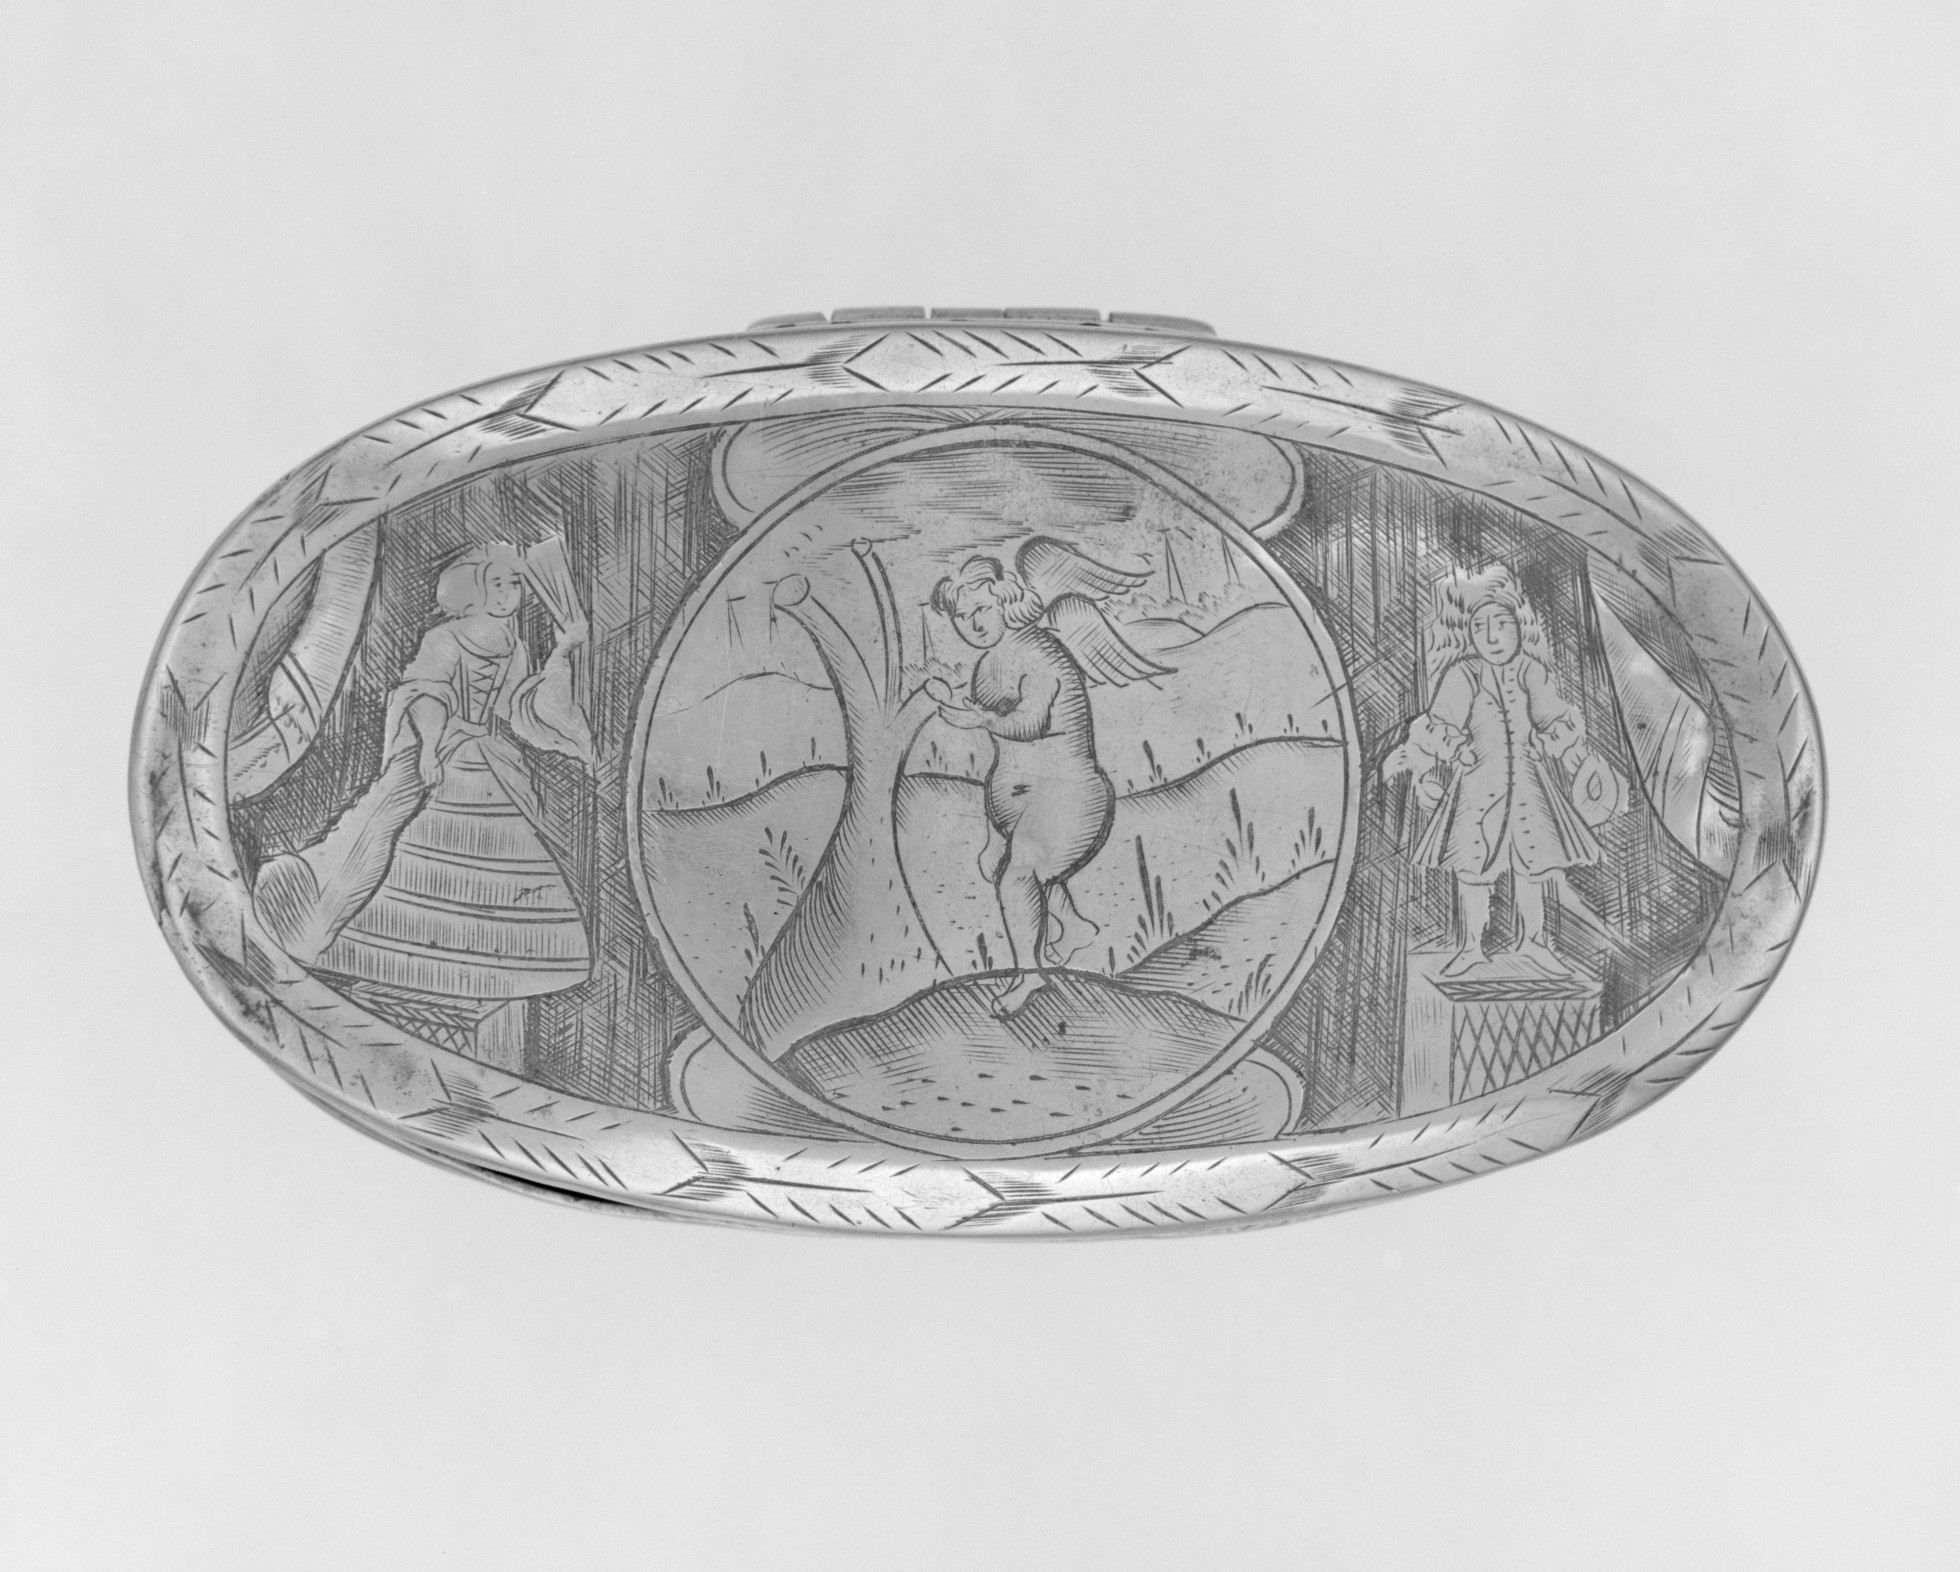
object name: tobacco box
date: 1701-1800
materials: brass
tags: men,women